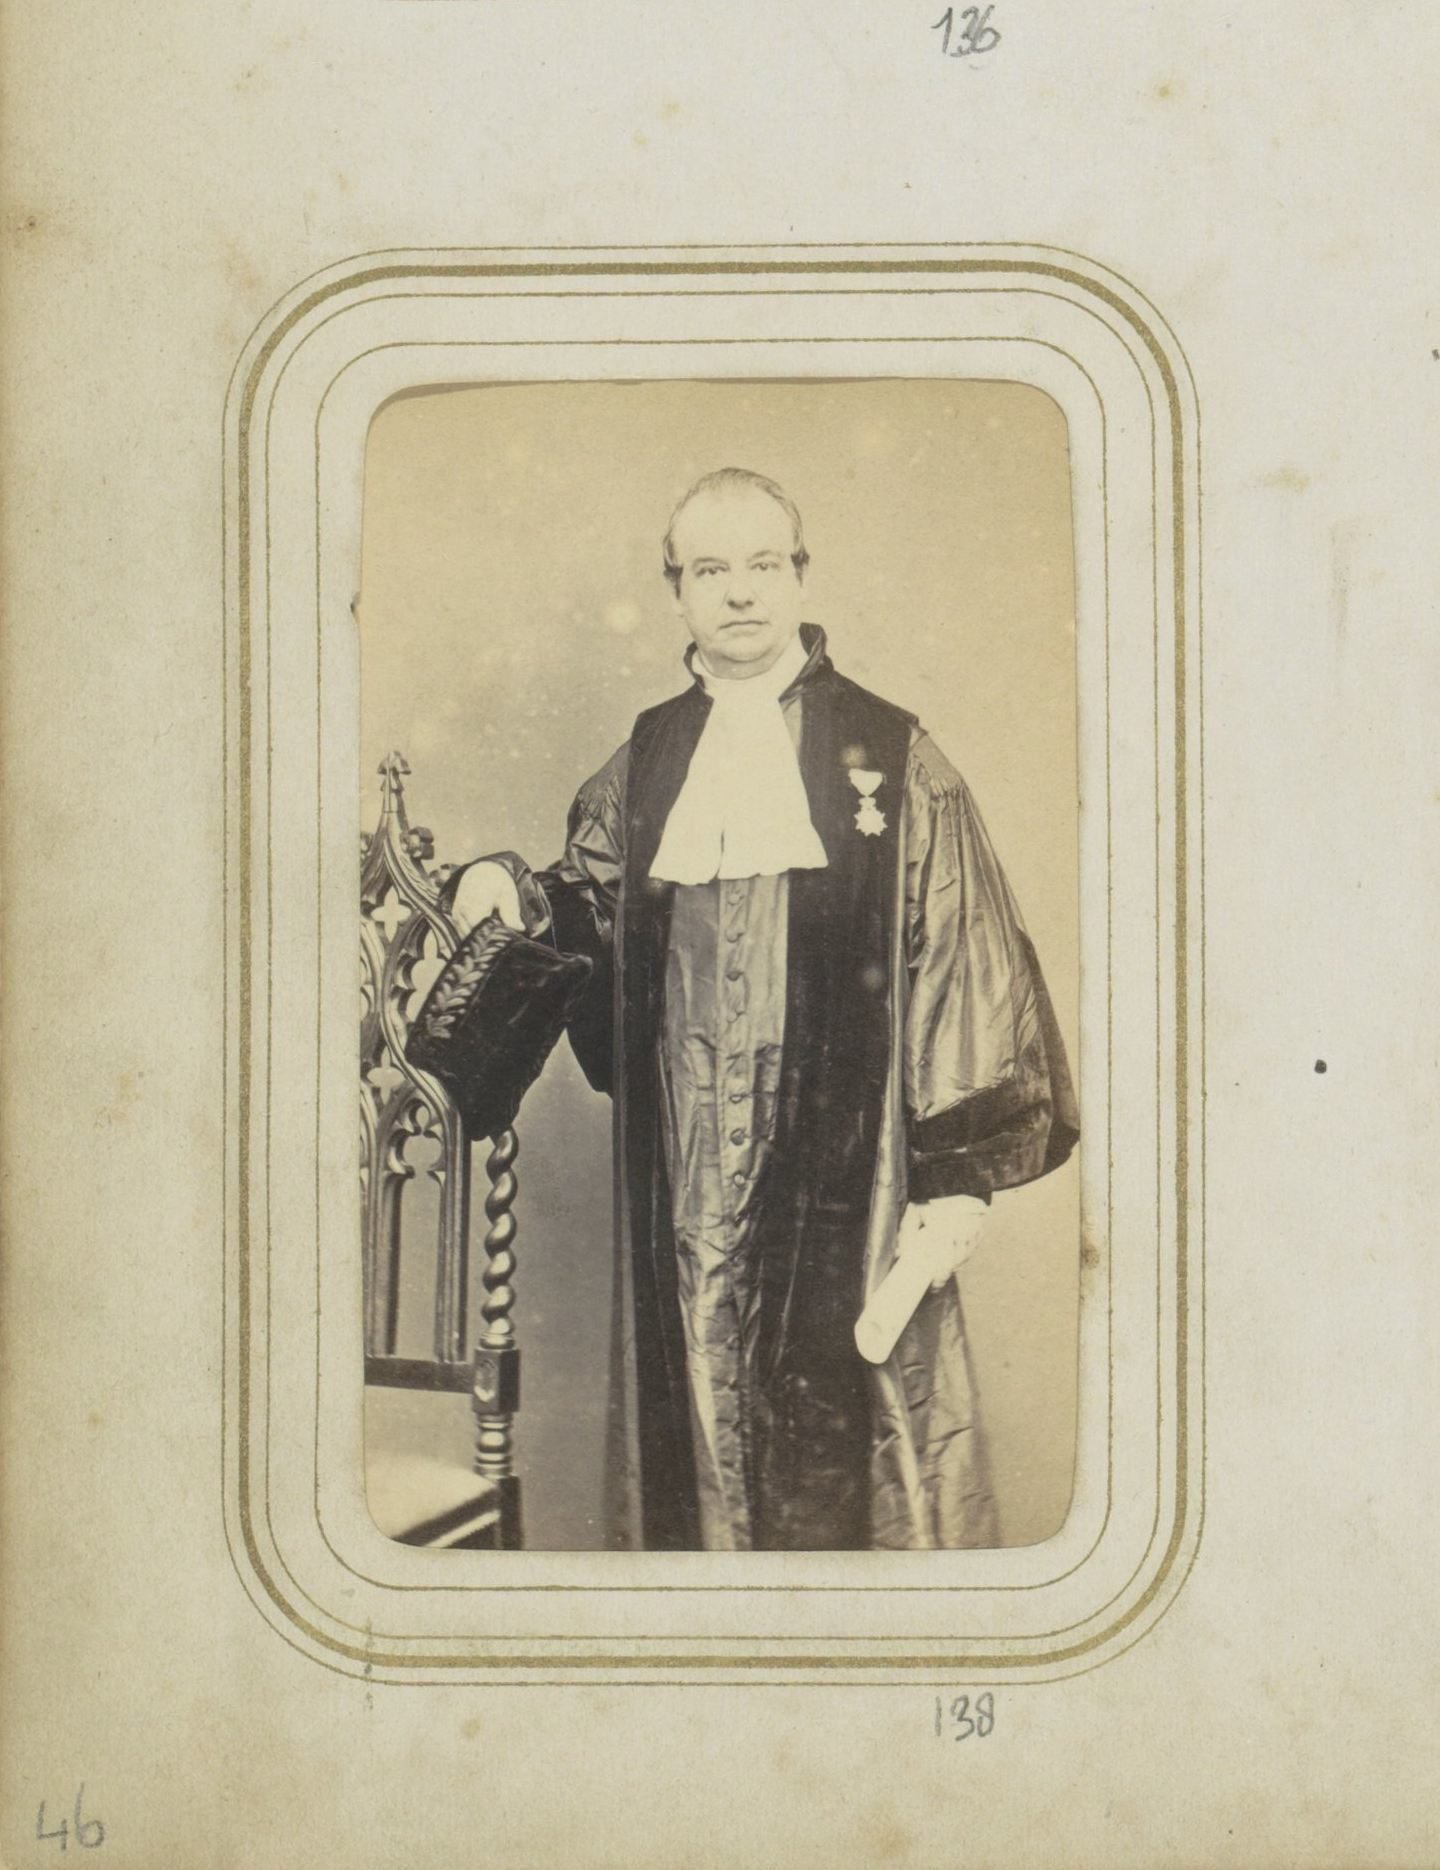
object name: carte de visite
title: Portret van A.J. Swart in toga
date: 1857-1880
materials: cardboard, photographic support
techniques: albumen print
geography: java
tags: the hague, professional clothes, studio requisites ~ photographer, head-gear, neck-gear: jabot (+ men's clothes), historical persons, family, relationship, descent, decorations, honours (as symbols of the state, etc.), java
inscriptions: address: ‘Java’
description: Onderdeel van Familiealbum van H.W.F. Ligtenberg en L.M. Swart met 149 foto's en cartes-de-visite.